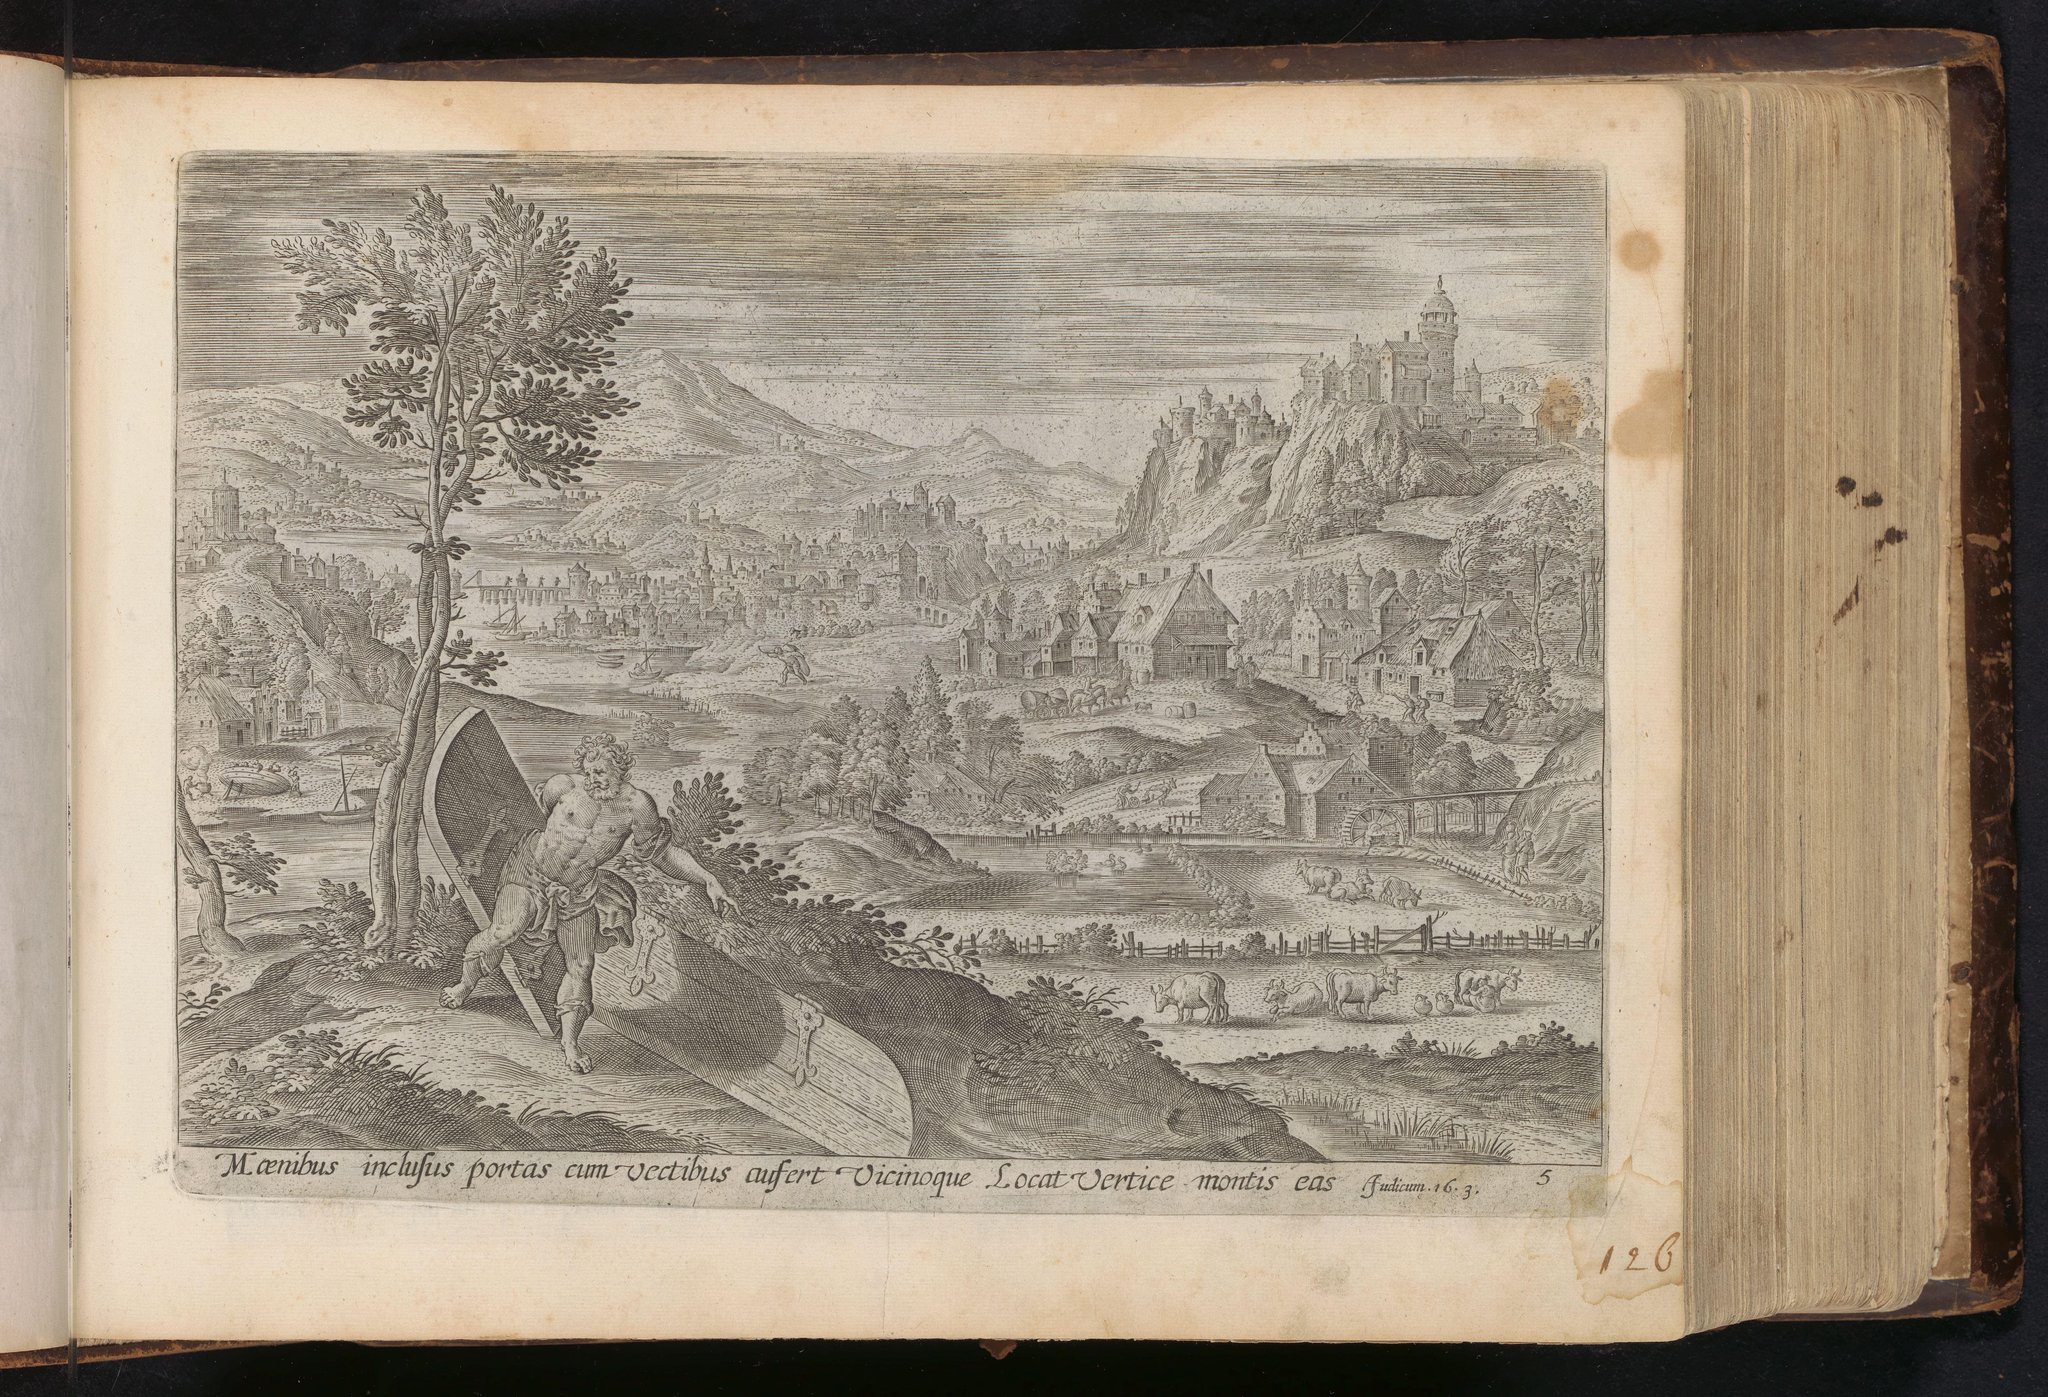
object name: album leaf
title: Geschiedenis van Simson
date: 1579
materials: paper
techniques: engraving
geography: alkmaar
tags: samson carries the doors on his shoulders to the top of a hill near hebron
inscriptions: number: ‘126’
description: Simson draagt de poorten van de stad Gaza op zijn schouders. Op de achtergrond de stad Gaza. Onder de voorstelling een verwijzing in het Latijn naar de Bijbeltekst in Ri. 16:3. Deze prent maakt deel uit van een album.